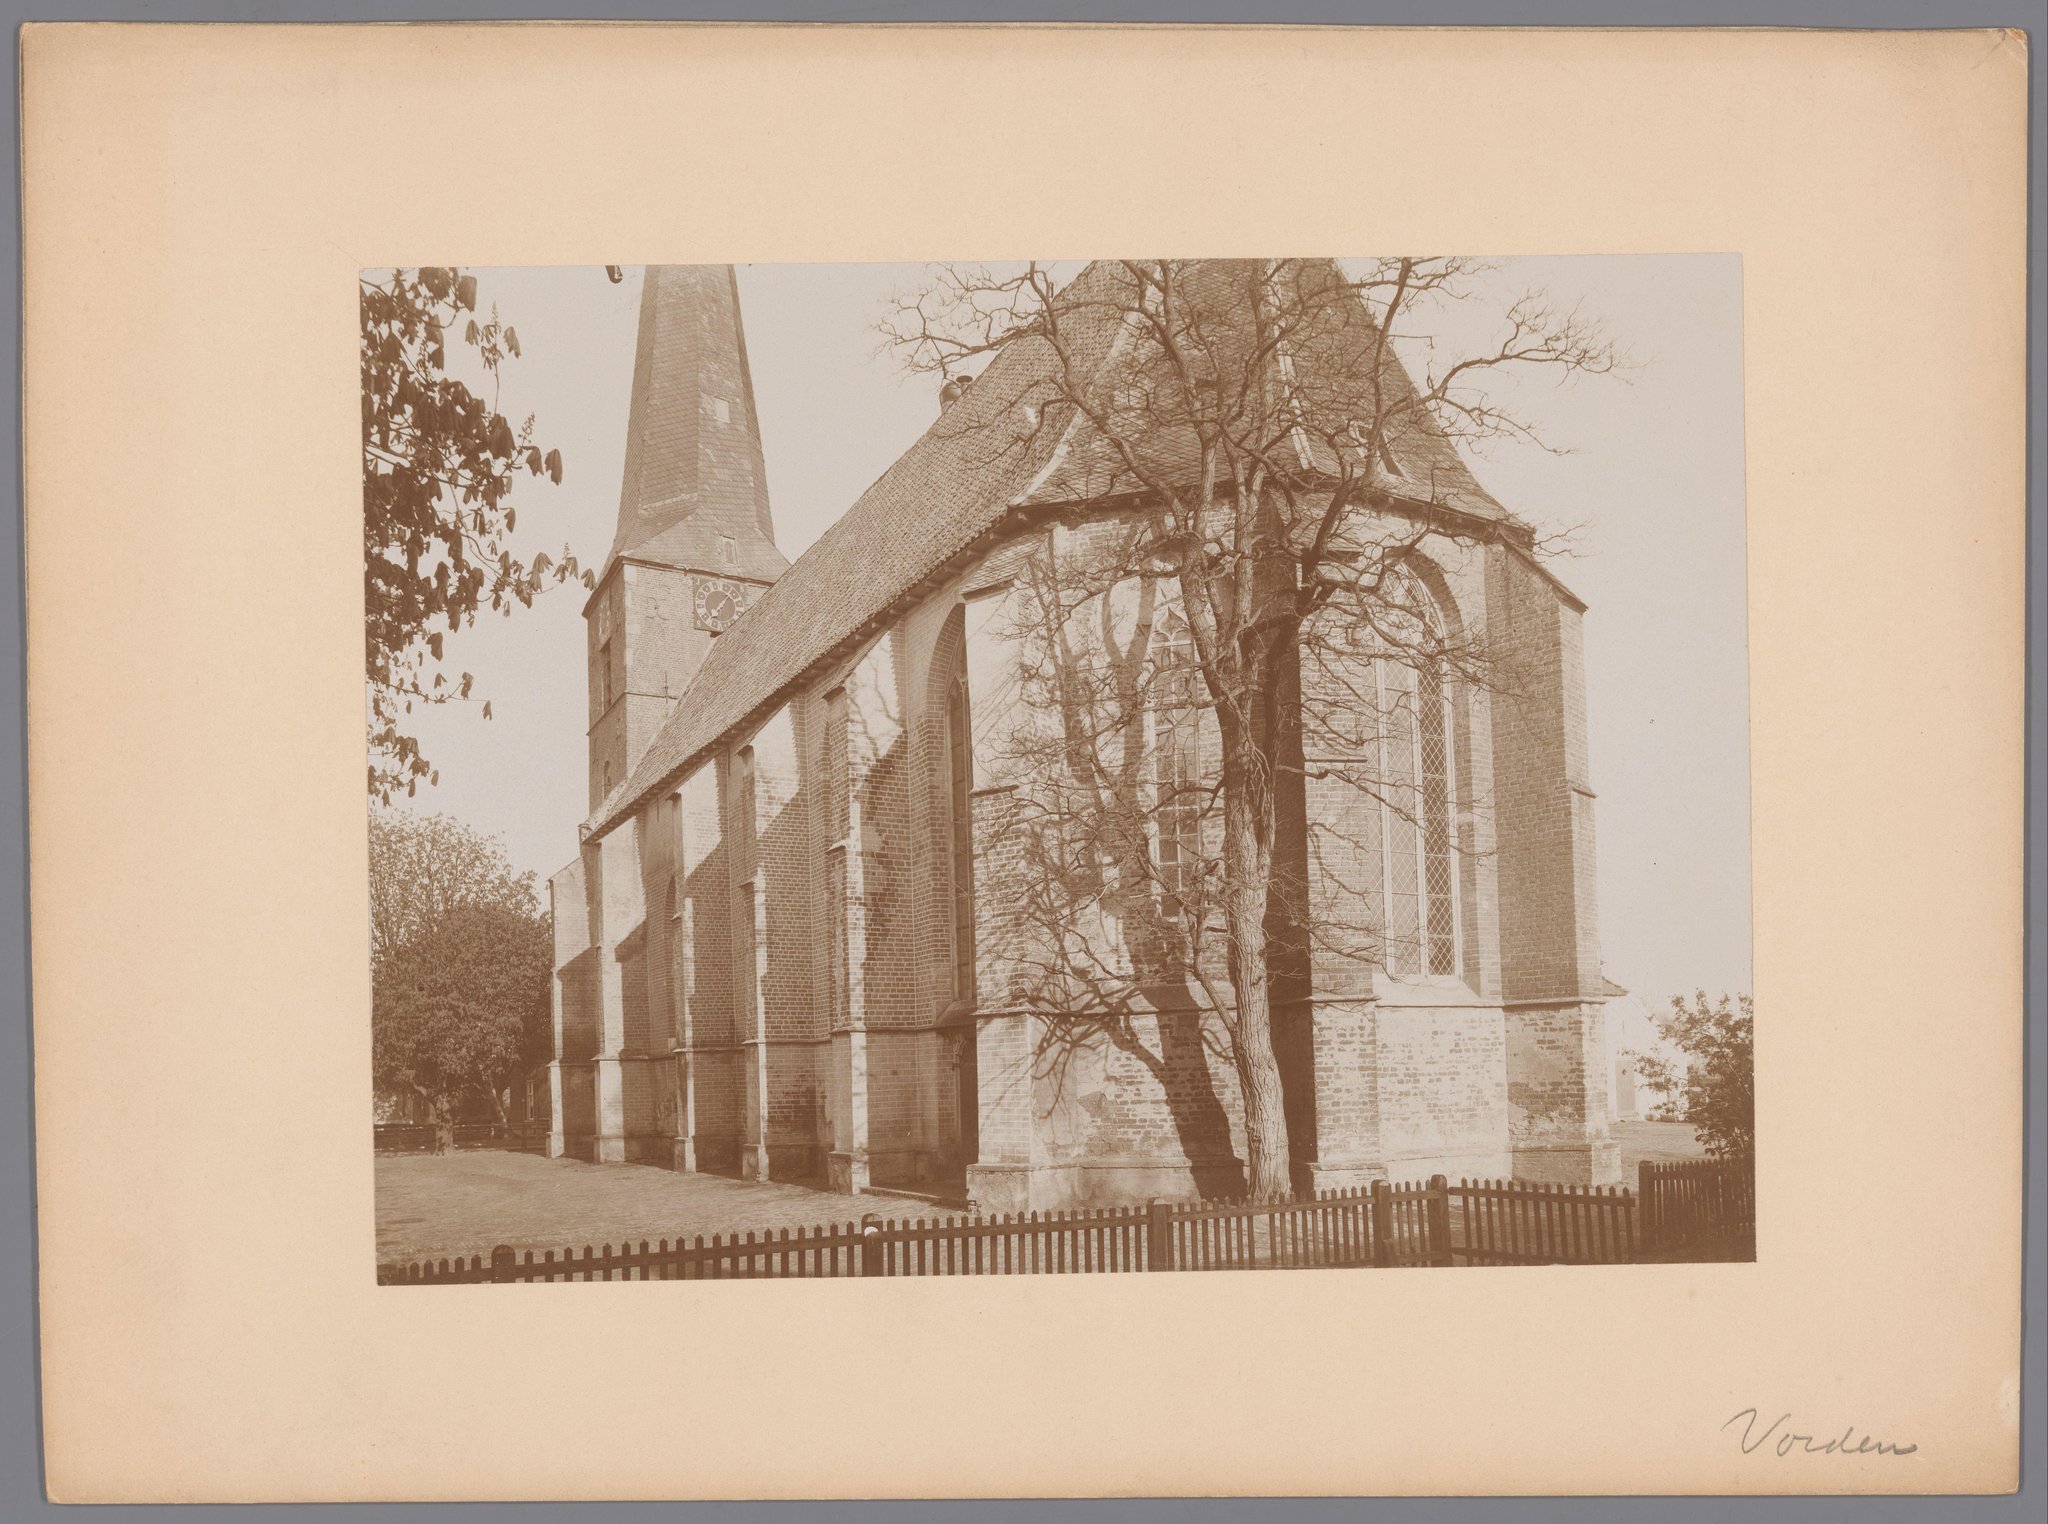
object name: photograph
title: Gezicht op de Dorpskerk of Antoniuskerk te Vorden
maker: anoniem (monumentenzorg)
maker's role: fotograaf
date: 1896-1986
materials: cardboard, photographic support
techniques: collodion silver print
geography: vorden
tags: church (exterior)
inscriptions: annotation: ‘Vorden’, annotation: ‘Vorden (G.)/ N.H. kerk/ 30 april 1896’